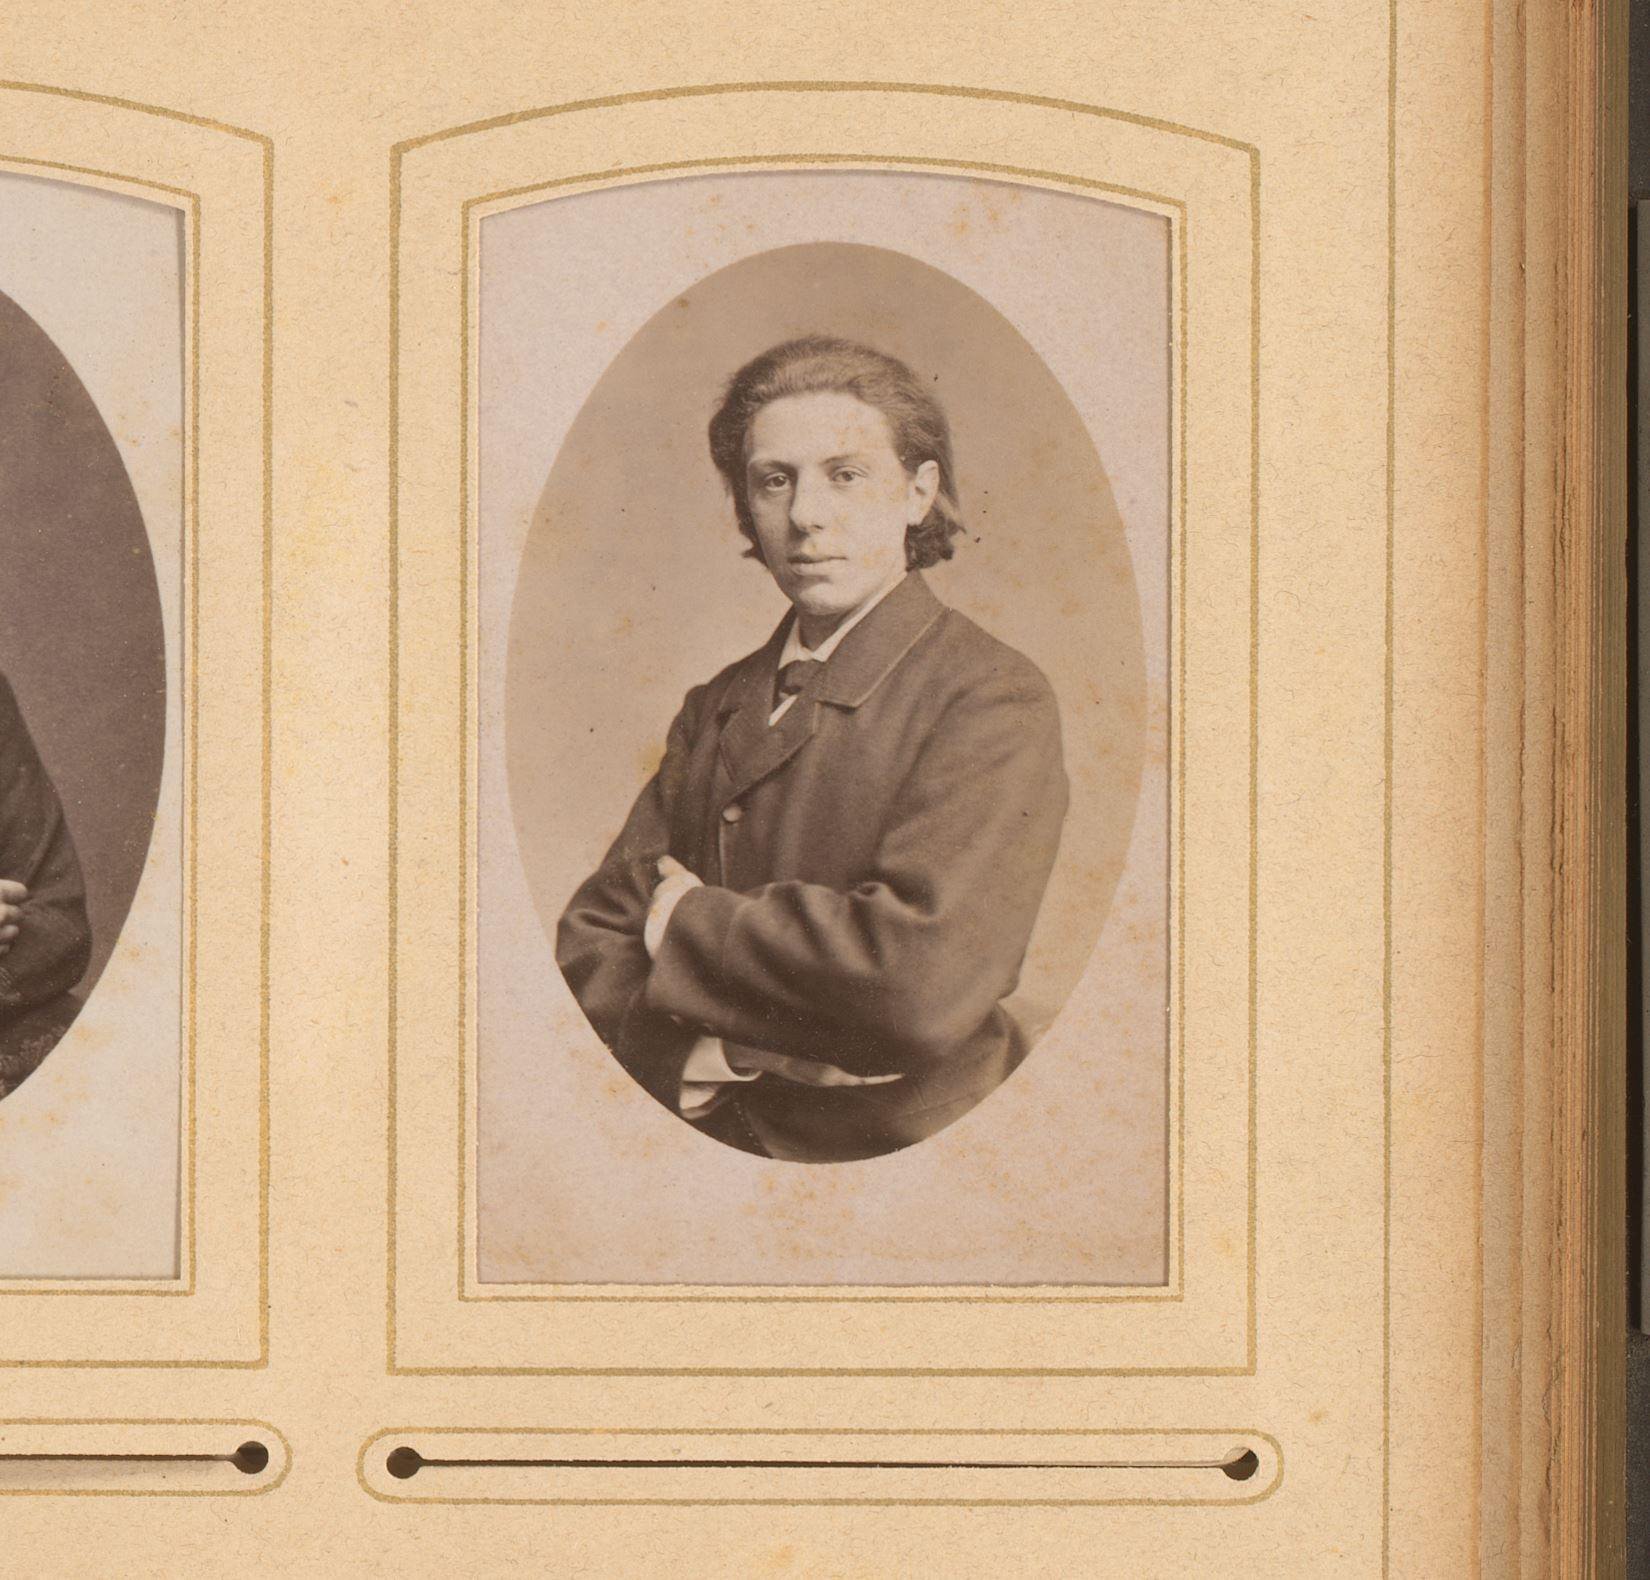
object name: carte de visite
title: Portret van een jonge man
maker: louis robert werner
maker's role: fotograaf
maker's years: 1834-1896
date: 1866-1896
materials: cardboard, photographic support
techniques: albumen print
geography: amsterdam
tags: historical persons, youth, adolescent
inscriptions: inscription: ‘L. R. Werner/ vorheen/ P. Carstensen./ Nieuwendyk H. 150./ AMSTERDAM./ Voor nabestellingen blijft de Plaat bewaard.’